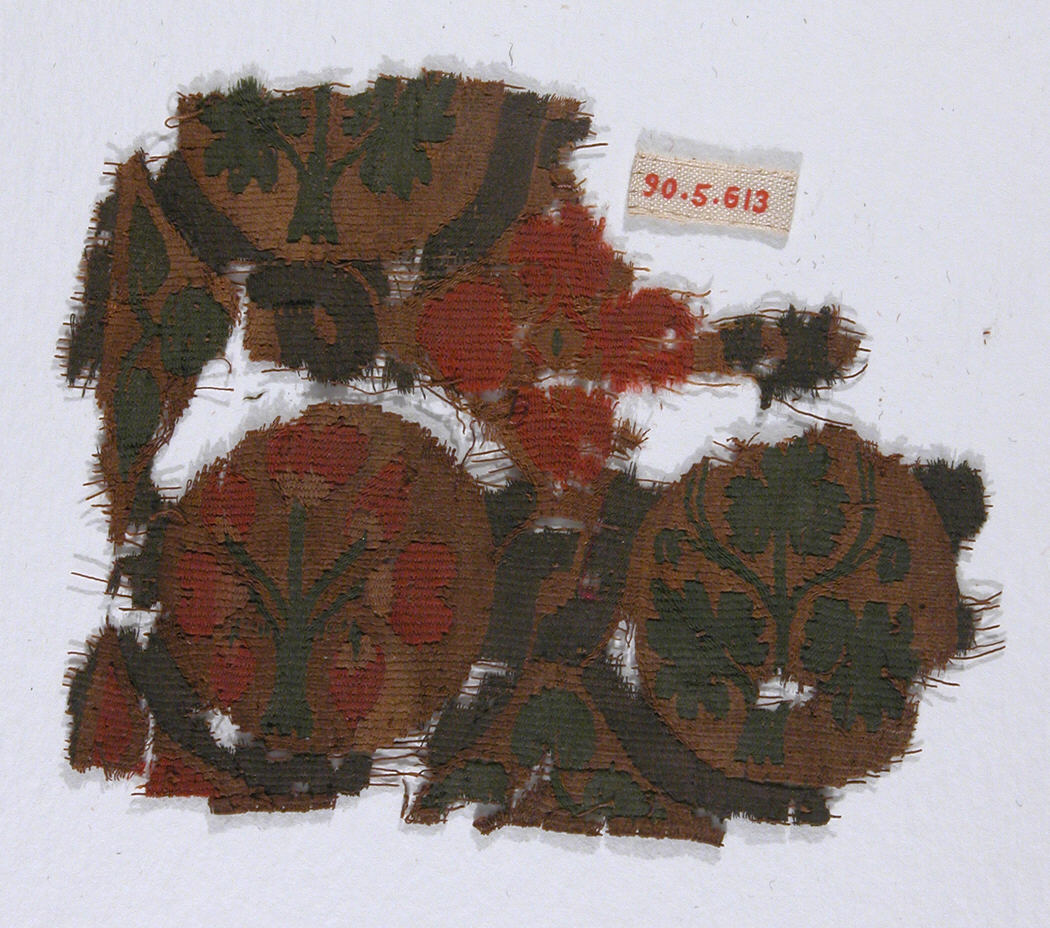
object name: textile fragment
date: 301-400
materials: linen, wool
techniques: weave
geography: egypt